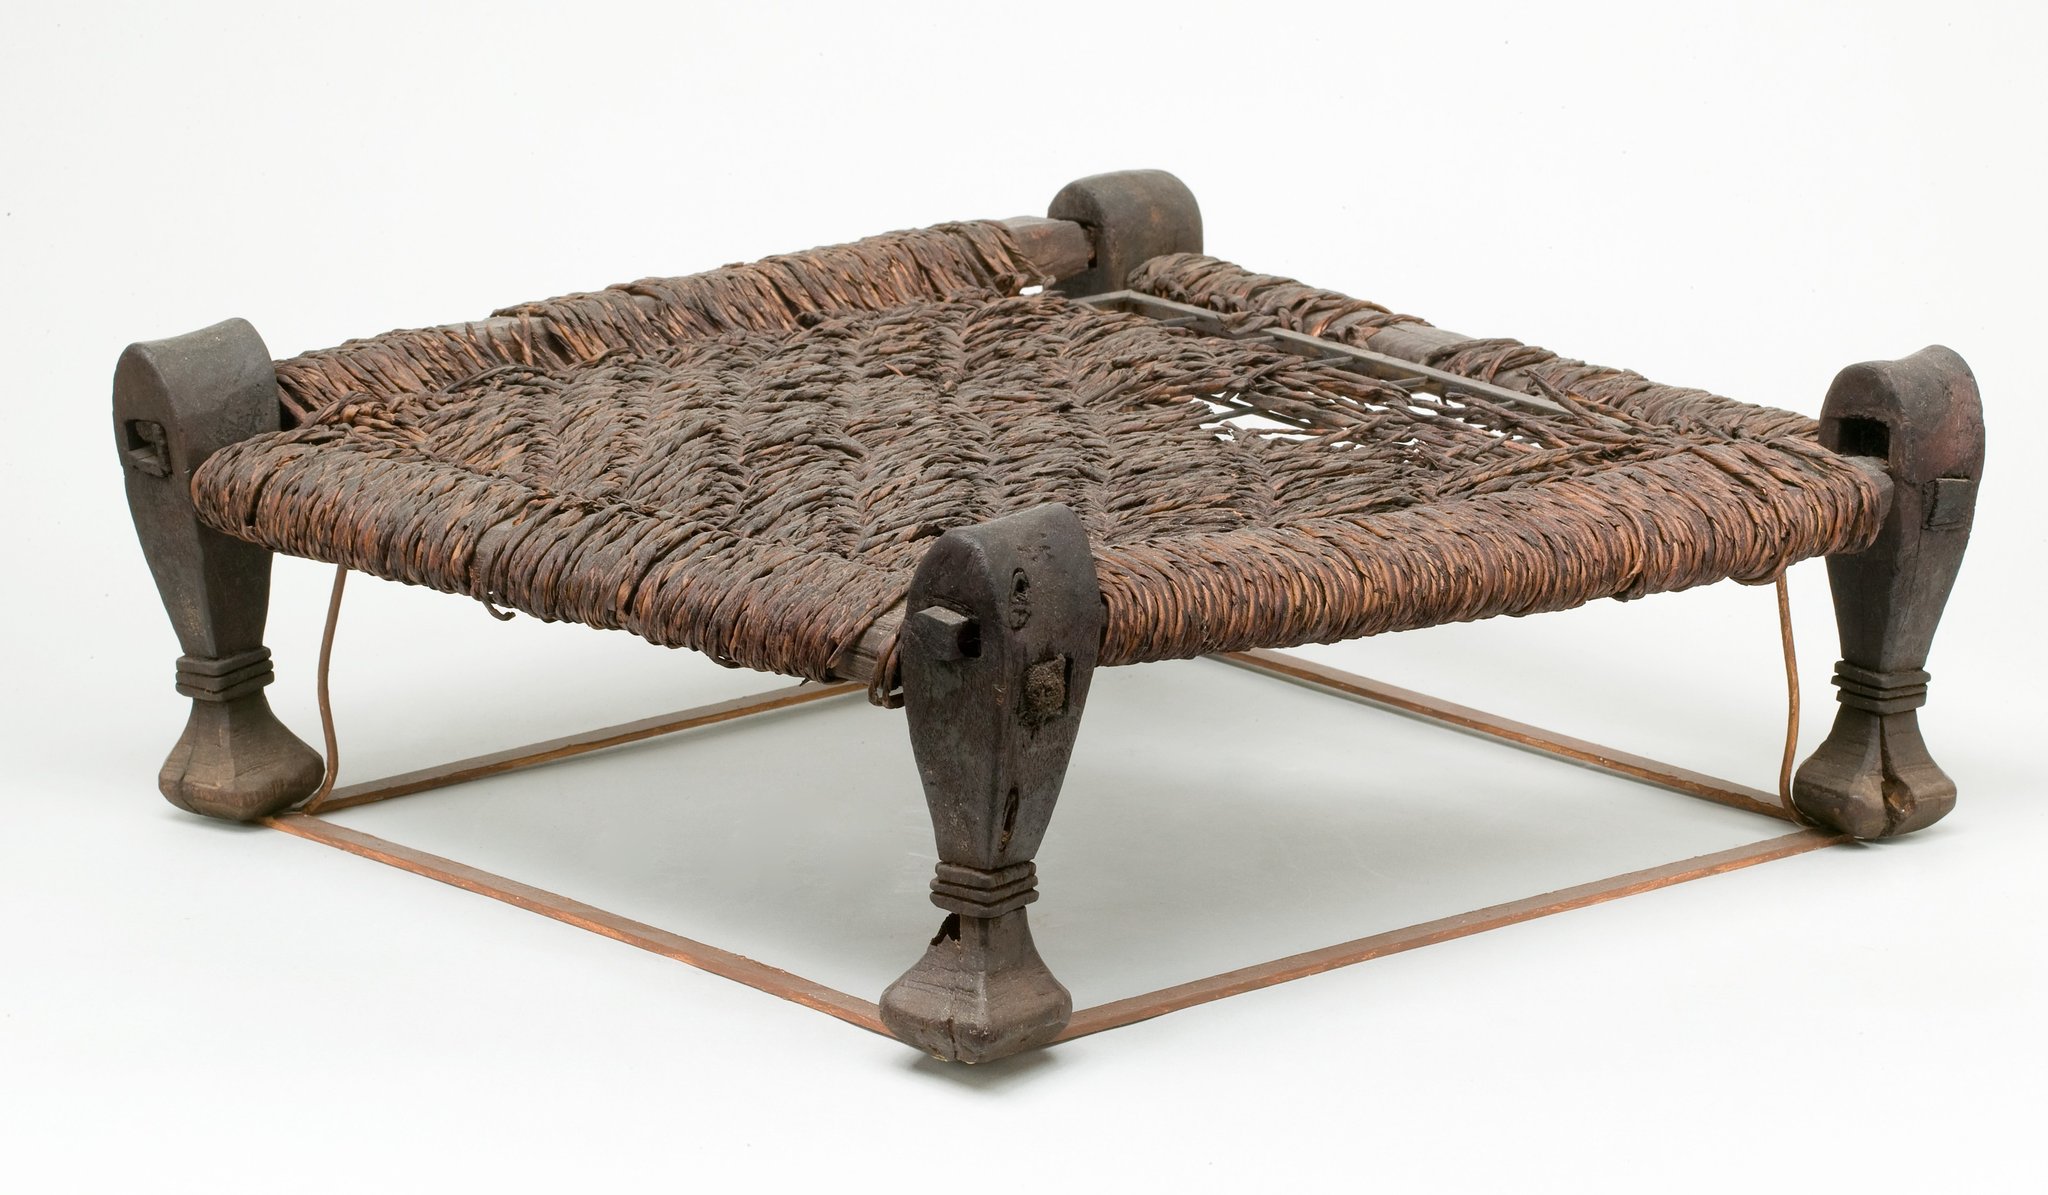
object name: stool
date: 1550-1295 BCE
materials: wood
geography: egypt